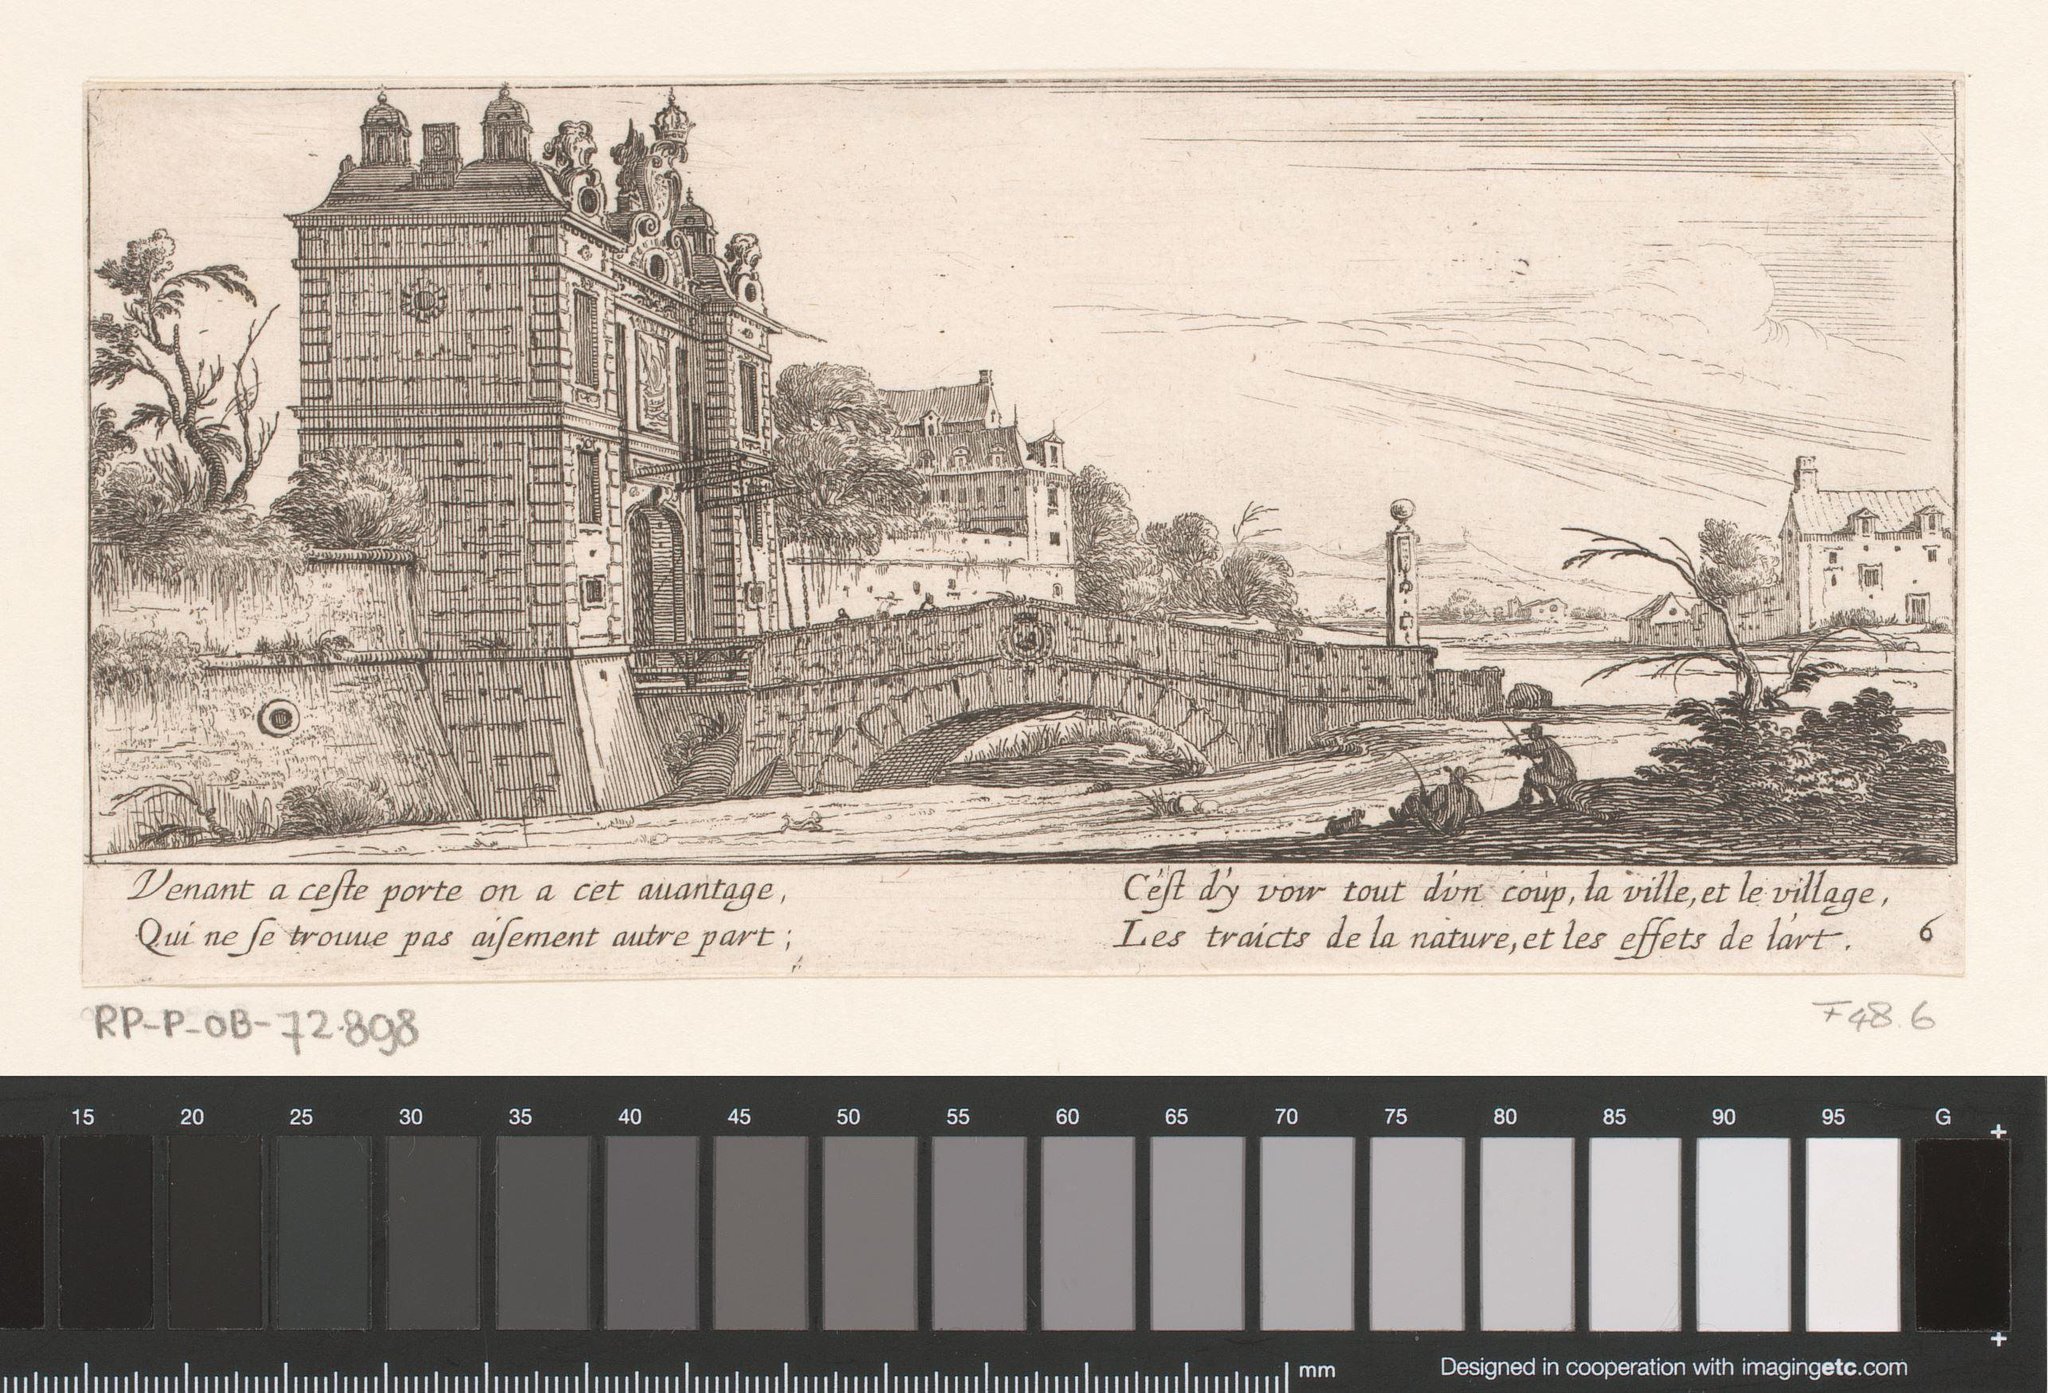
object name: print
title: Porte de St. Honoré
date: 1655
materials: paper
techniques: engraving, etching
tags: city-gate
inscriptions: collector's mark: Lugt 240